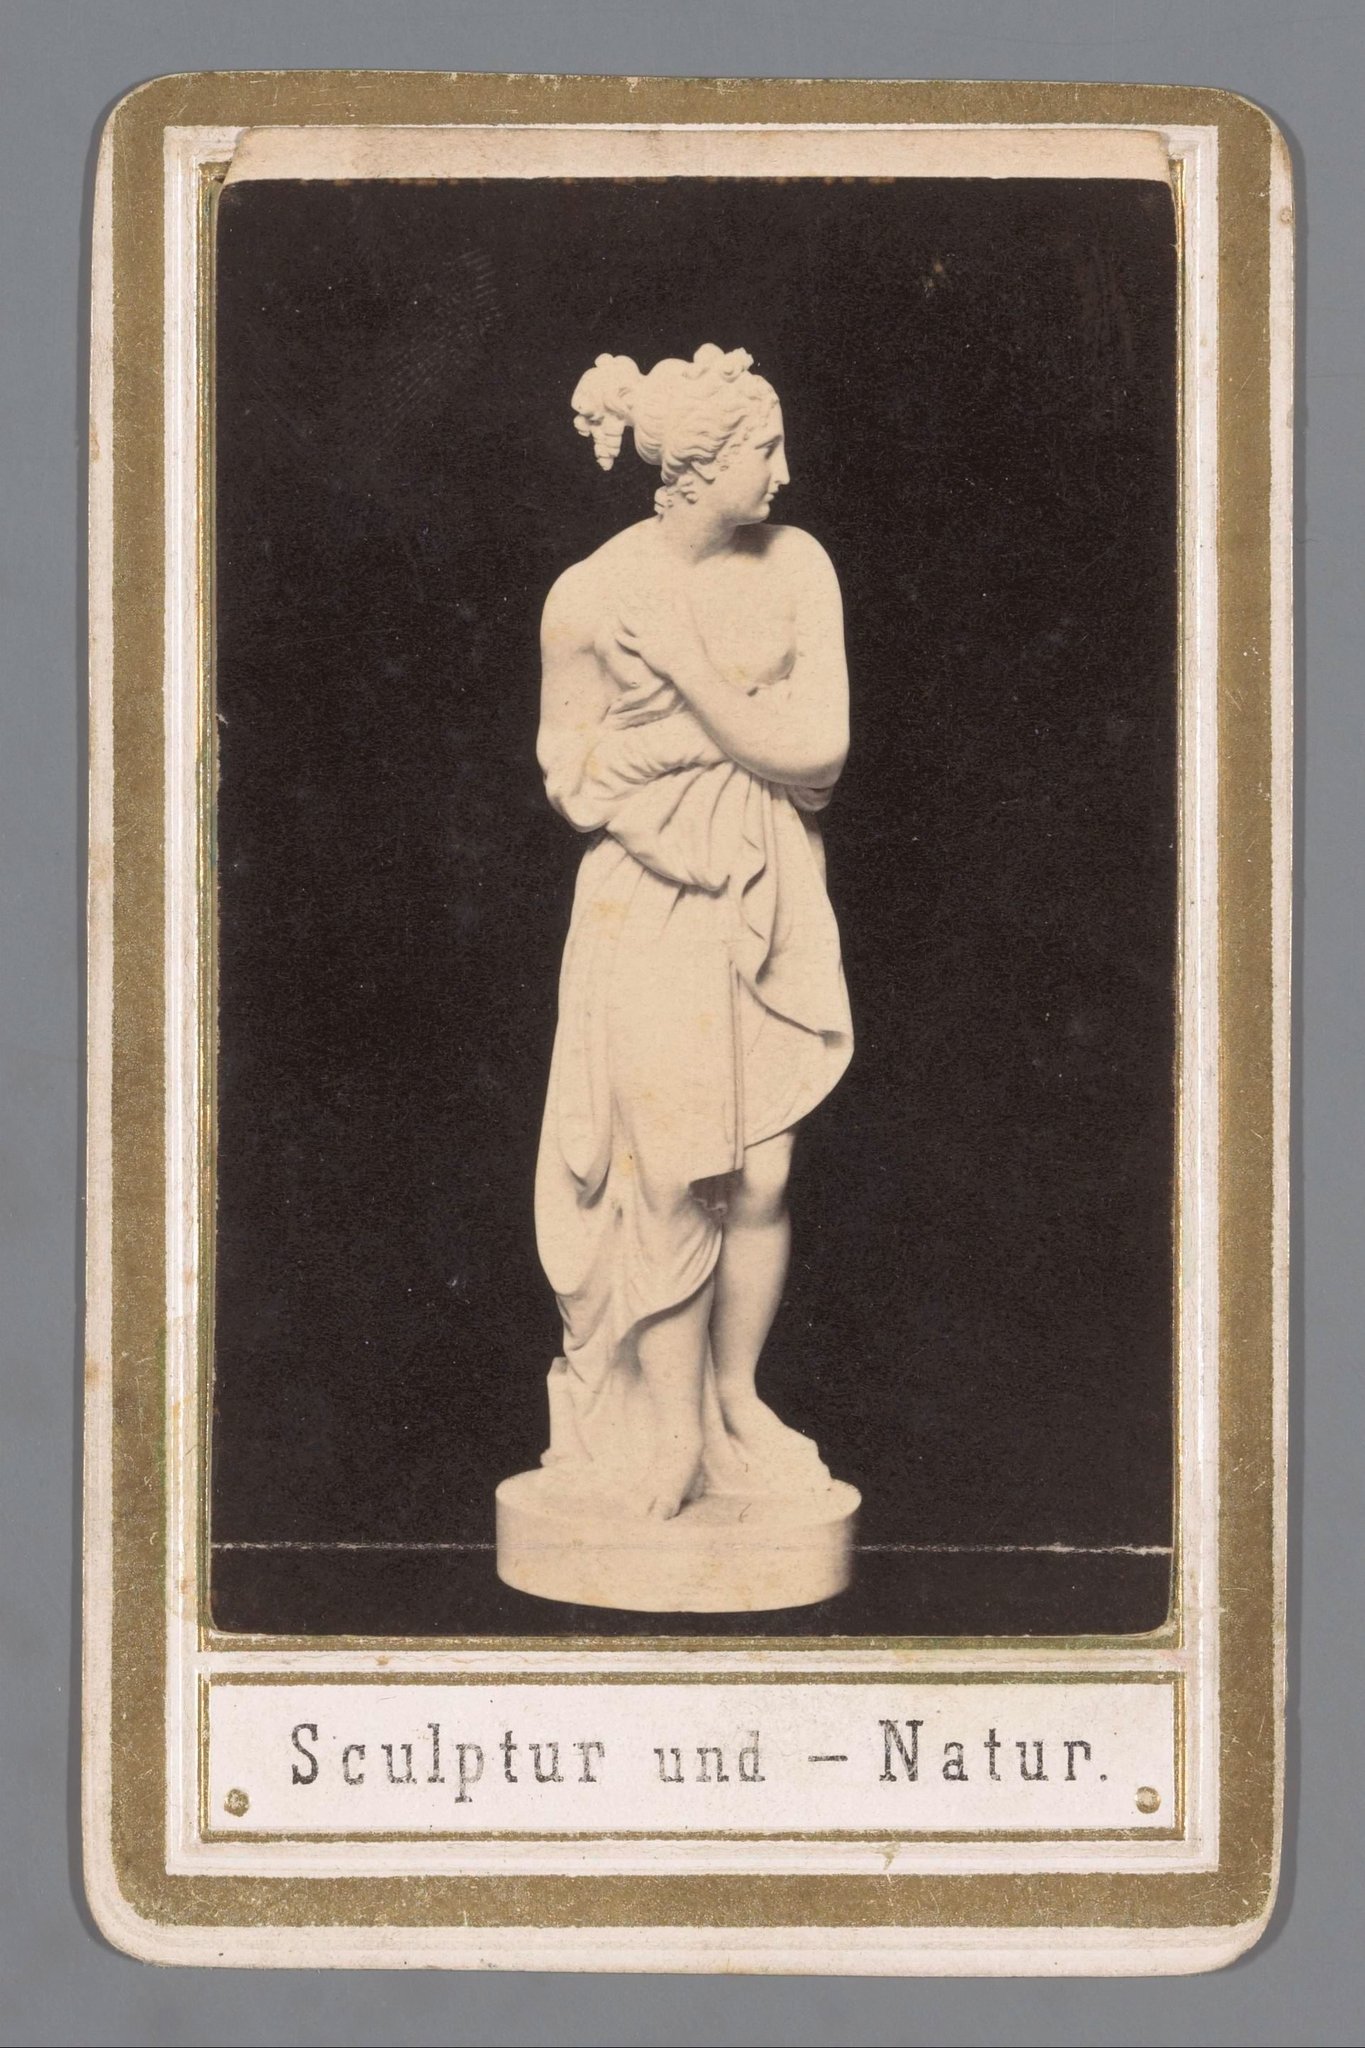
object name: photograph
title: Carte-de-visite with Canova’s Venus Italica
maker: Anonymous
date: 1850-1900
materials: cardboard, paper, photographic support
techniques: albumen print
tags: piece of sculpture, reproduction of a piece of sculpture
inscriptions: inscription: ‘Venus./ (Canova.)/ Im neuen Jahr zieh' nur dorthin,/ Wo hübsch die Zimmernachbarin,/ Wo freundlich Du behandelst wirst,/ Wenn Du Dich in der Thür' mal irrst.’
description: The meaning of ‘Sculptur und – Natur’ (Sculpture and Nature) goes without saying. A semi-clad woman in the same pose as Canova’s Venus Italica is surprised by a male visitor. However, he fails to notice the child at play. The New Year’s greeting on the back advises to above all choose the proper front door. The maker of this card thus used Canova’s famous sculpture as a cover for his naughty depiction.